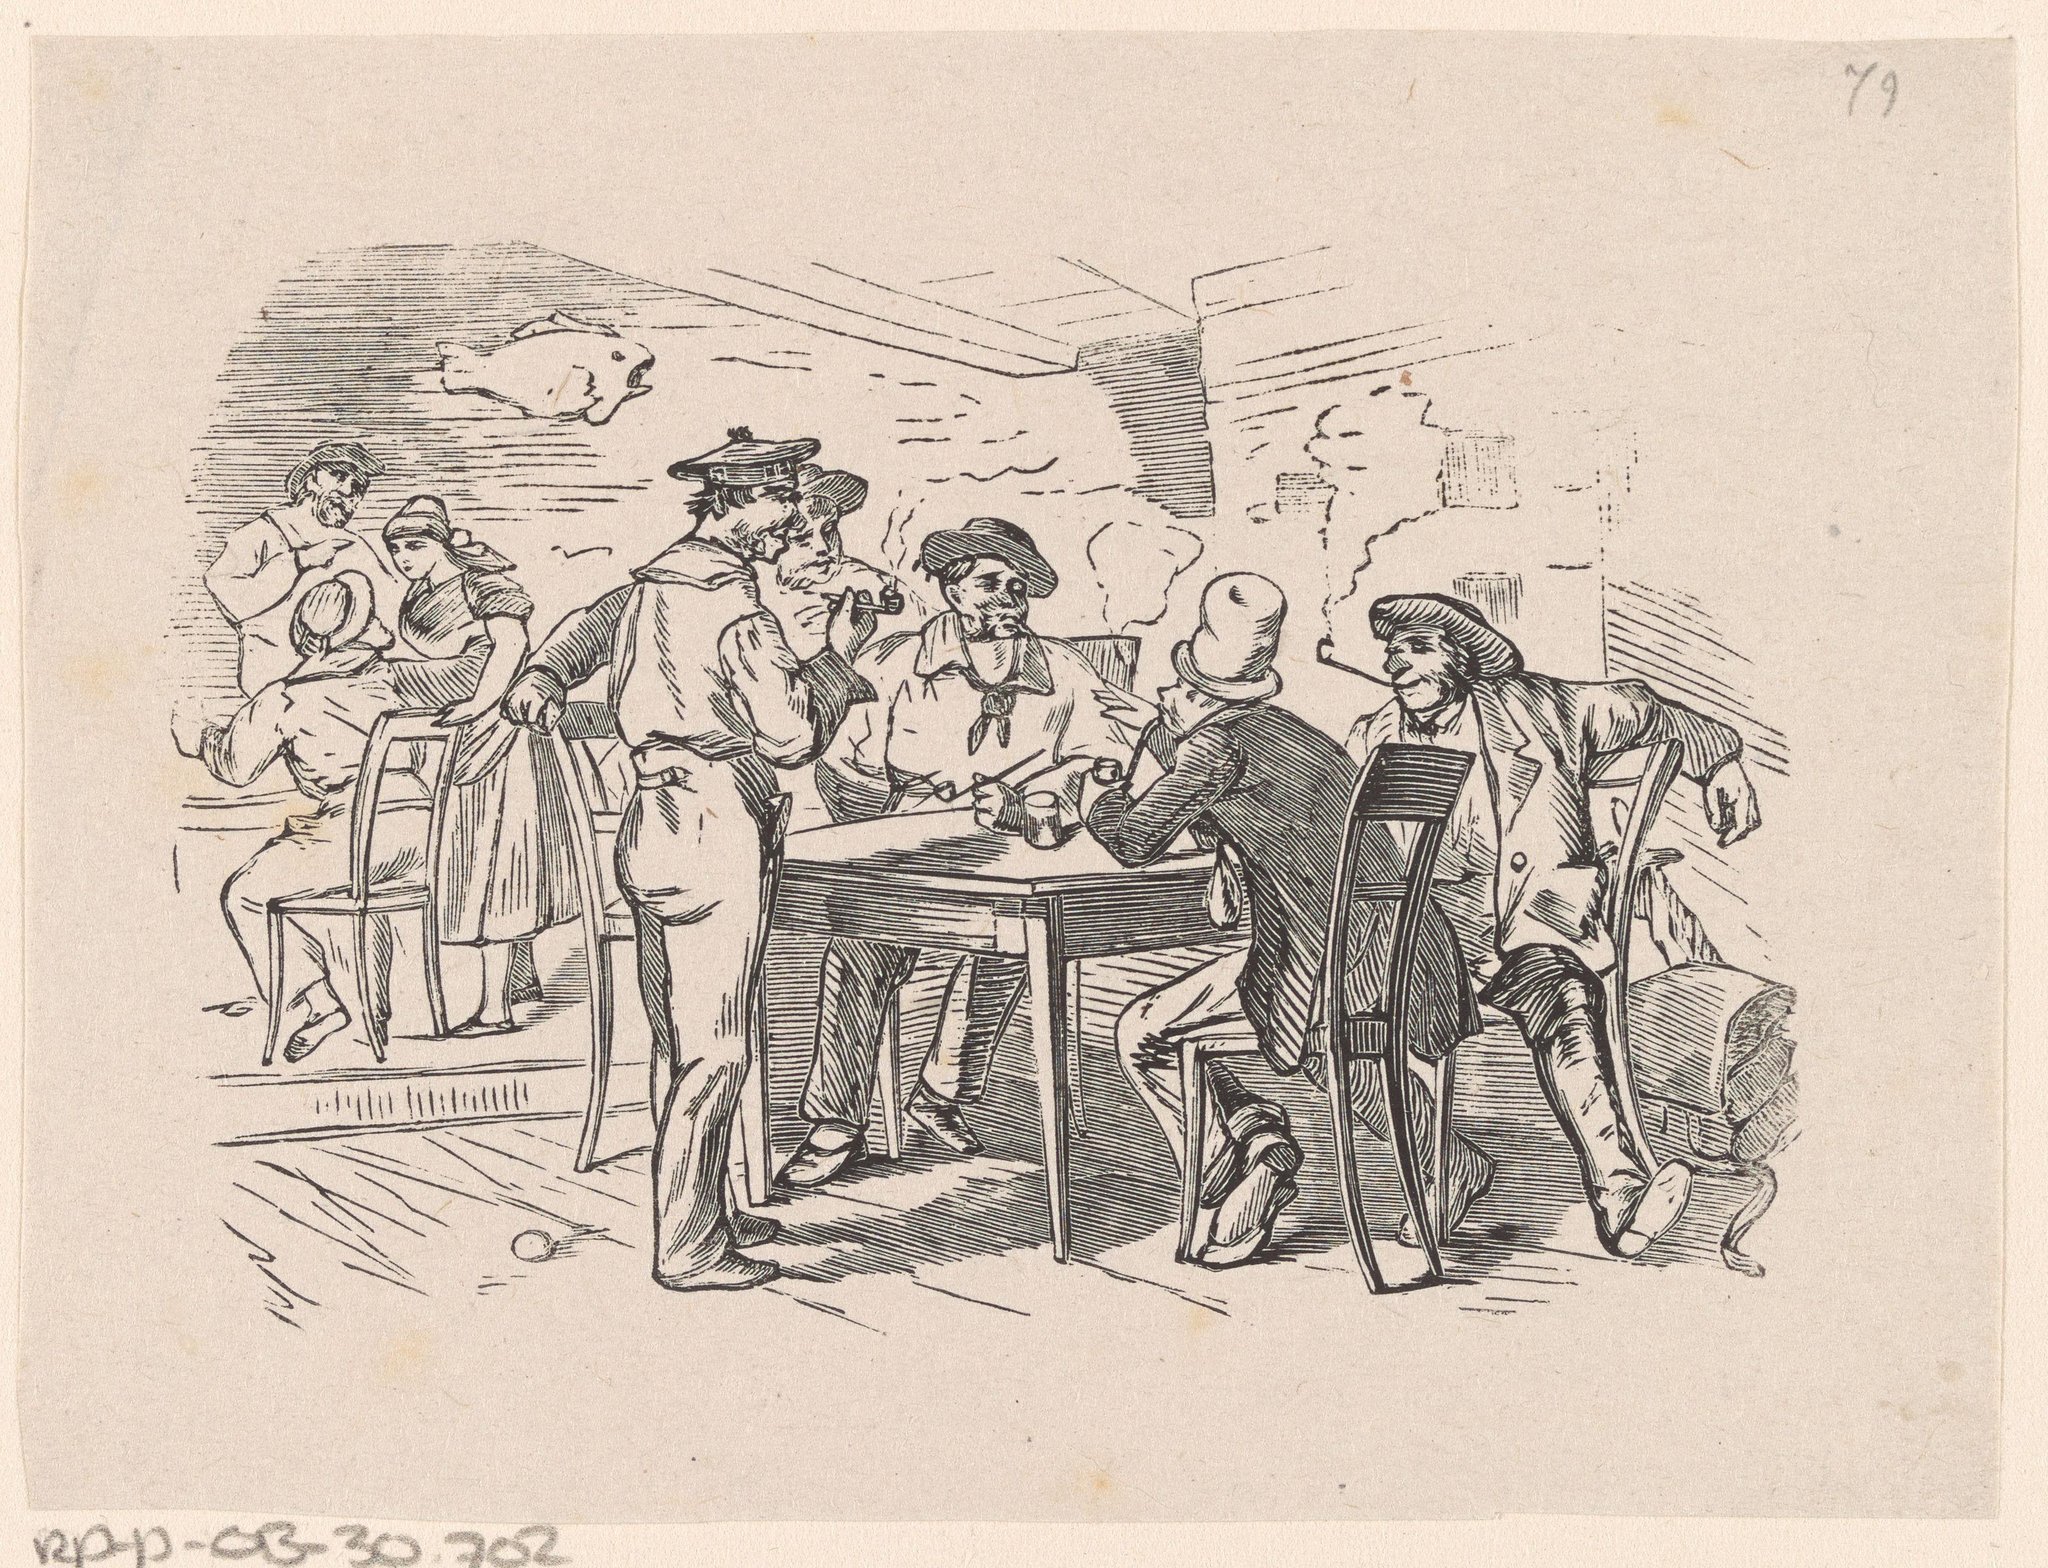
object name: print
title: Groep mannen rokend rondom een tafel in een café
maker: isaac weissenbruch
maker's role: print maker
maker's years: 1826-1912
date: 1836-1912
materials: paper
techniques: engraving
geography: netherlands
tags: adult man, inn, coffee-house, public house, etc., tobacco (+ taking (particular) foodstuffs: eating, drinking, smoking, chewing, etc.)